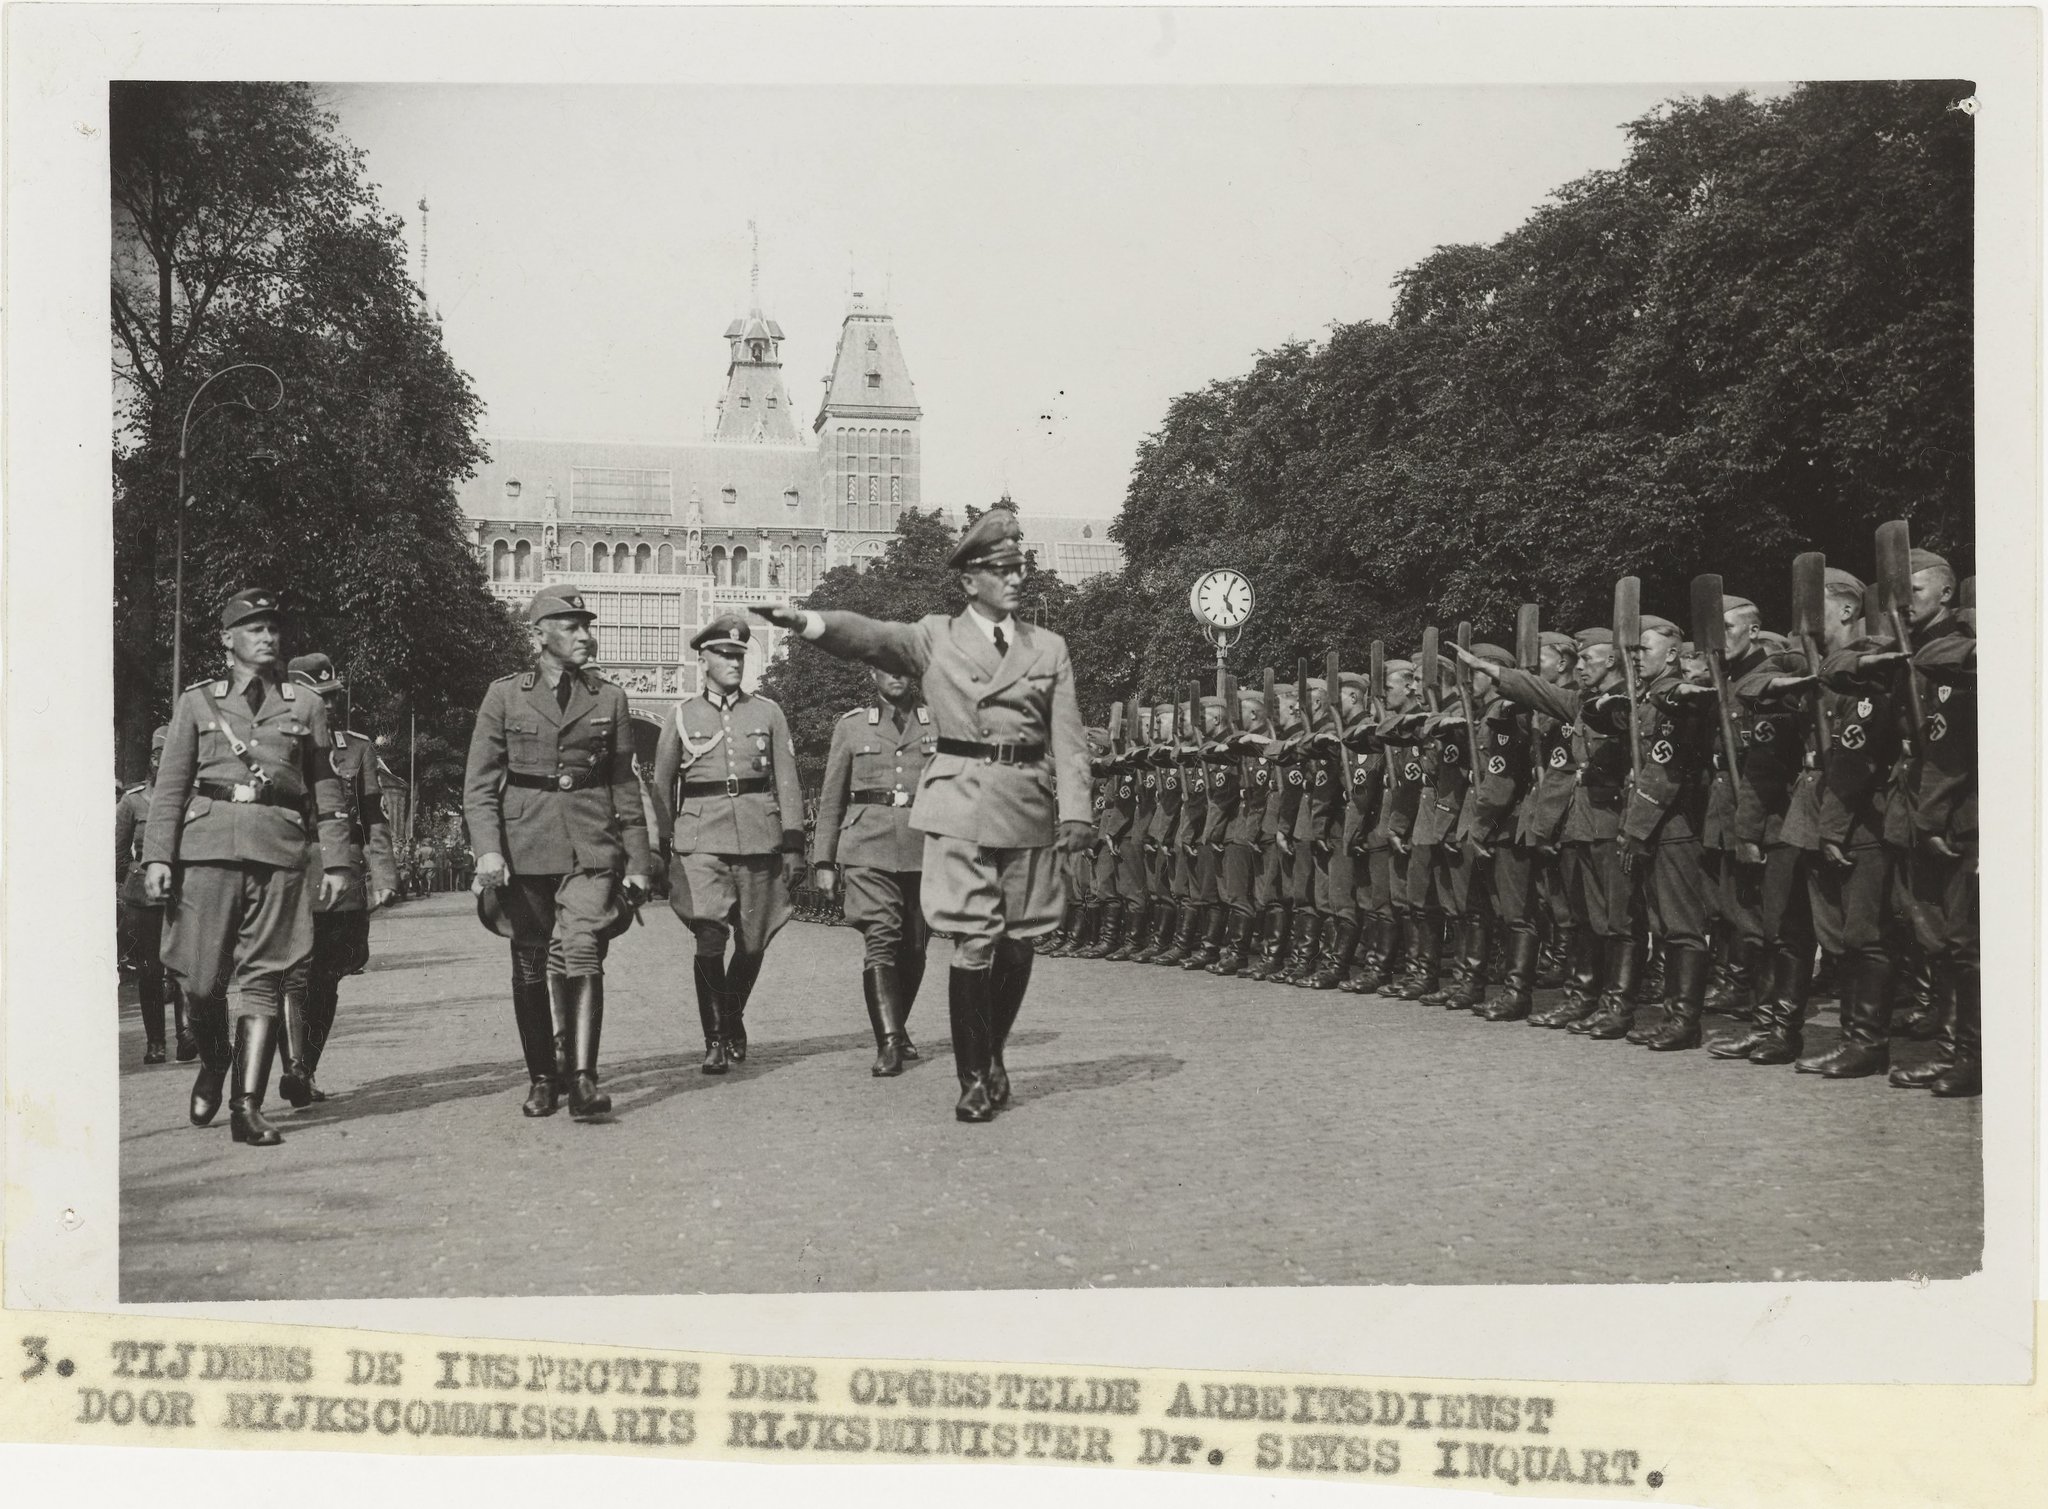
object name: photograph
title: Inspectie van de Duitse Reichsarbeitsdienst, opgesteld op het Museumplein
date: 1940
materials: photographic support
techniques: photography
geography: museumplein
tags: arthur seyss-inquart, military parade, pageant, amsterdam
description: Voor het Rijksmuseum staat de Duitse Reichsarbeitsdienst opgesteld, schop als een geweer over de schouder. Seyss Inquart inspecteert de mannen terwijl hij de Hitlergroet brengt. Tekststrookje aan foto geplakt.